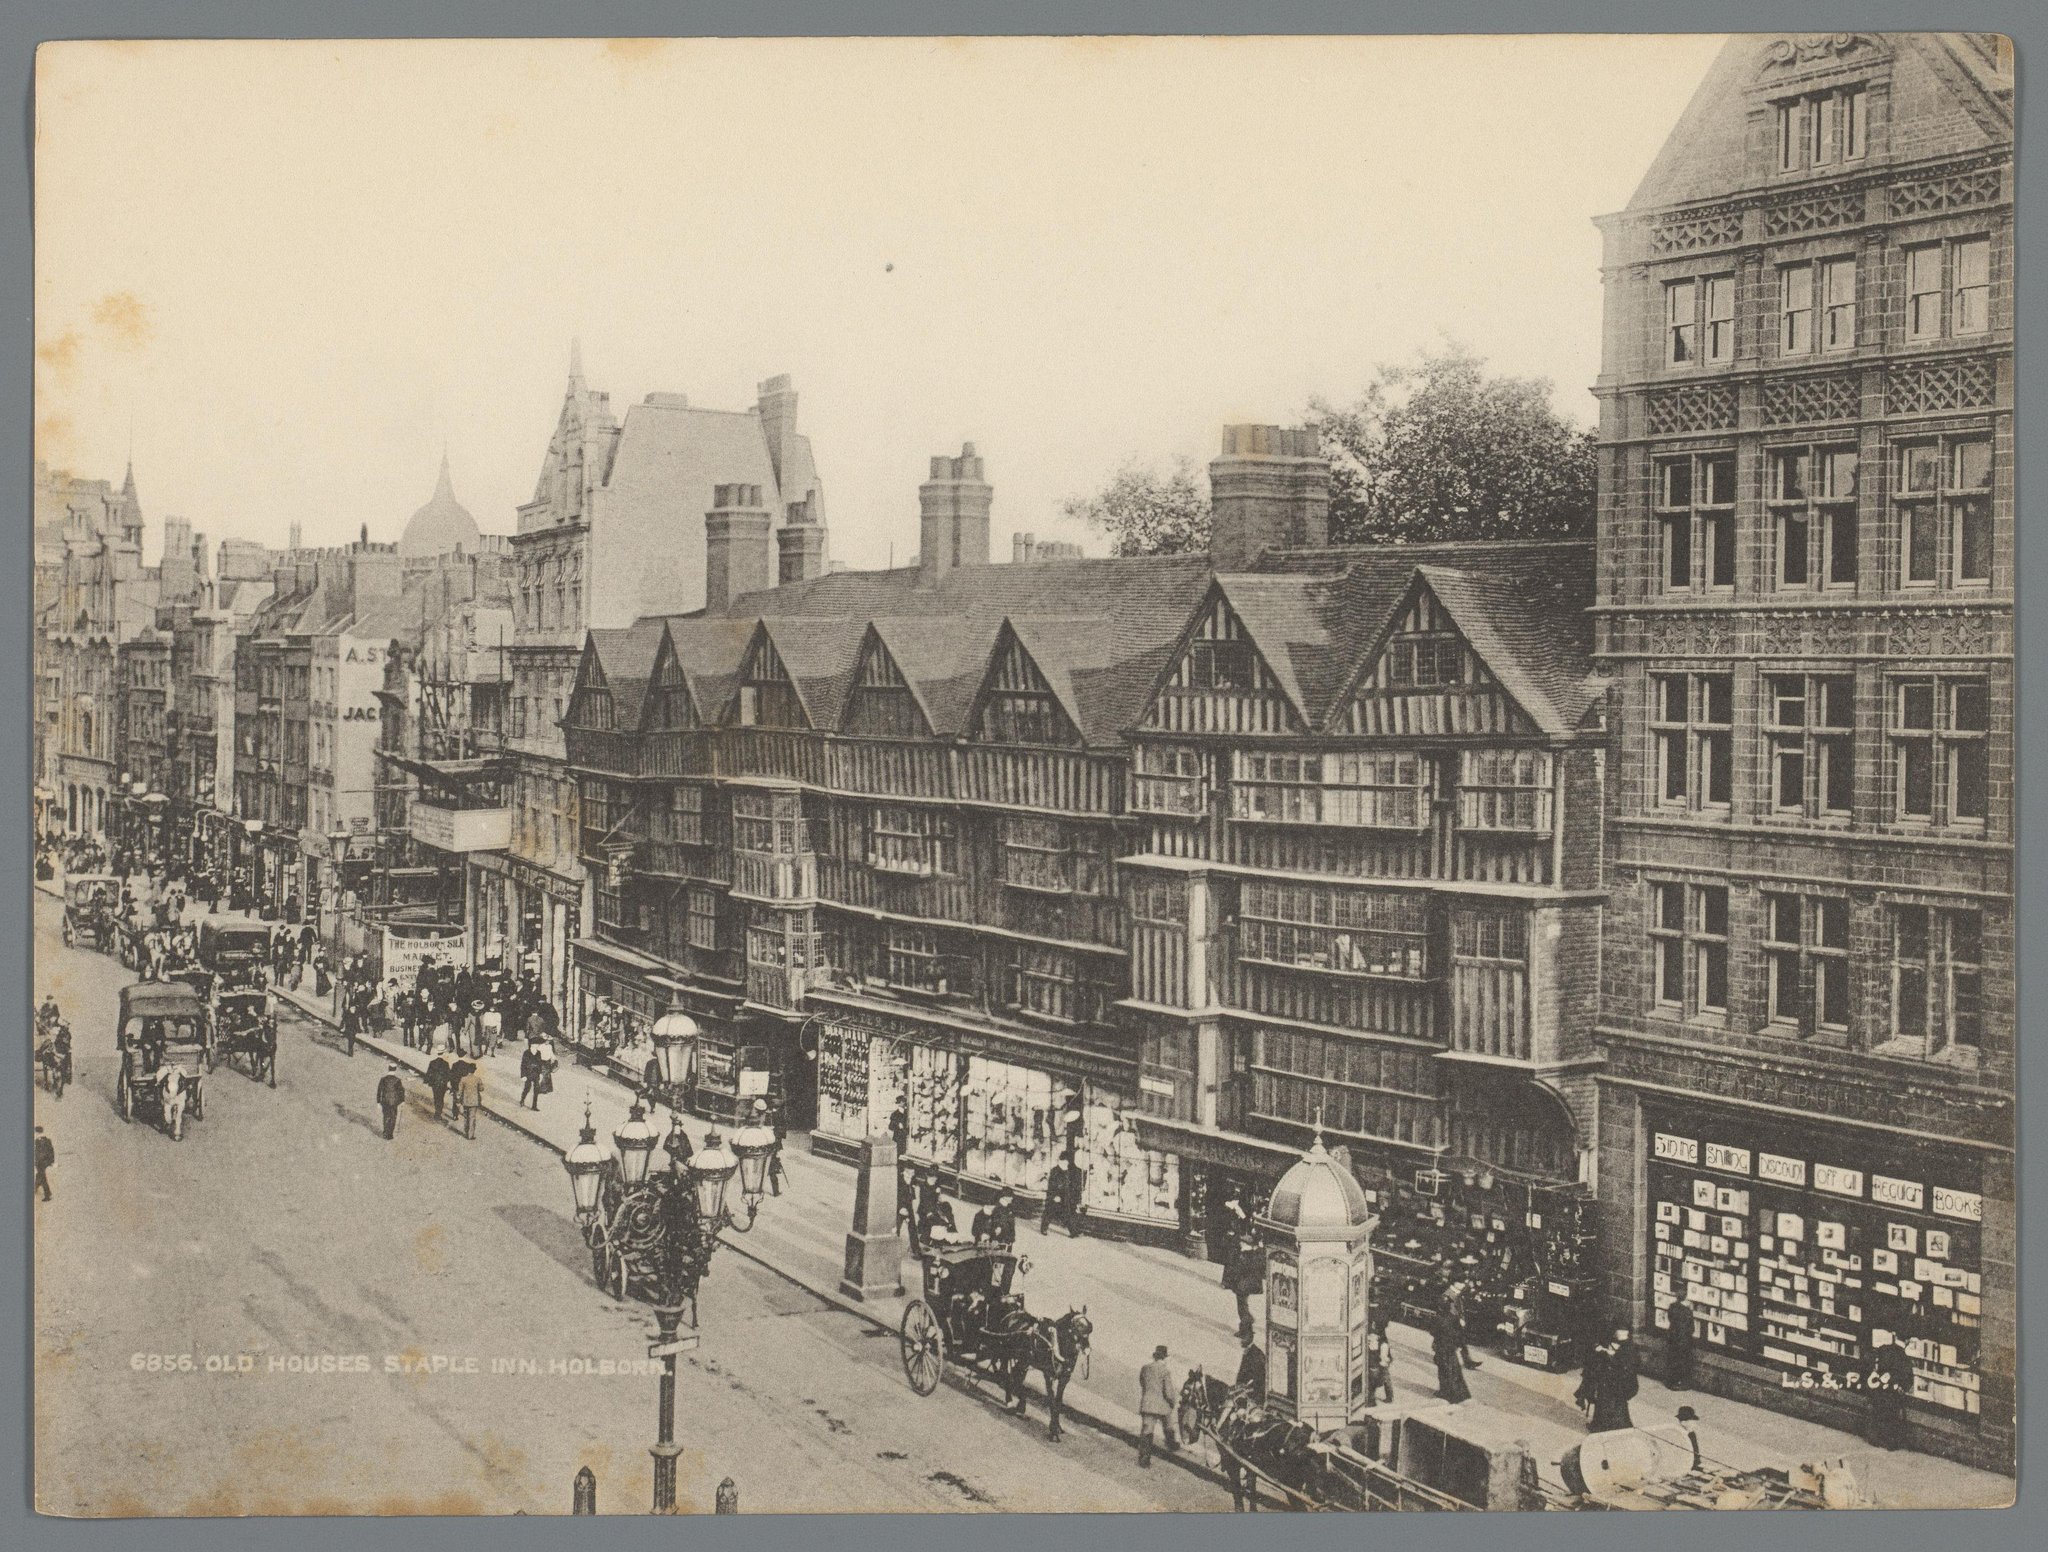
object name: photomechanical print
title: Gezicht op Staple Inn in Holborn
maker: Anonymous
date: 1870-1922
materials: paper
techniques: photograph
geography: london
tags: urban housing, street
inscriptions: number: ‘6856.’